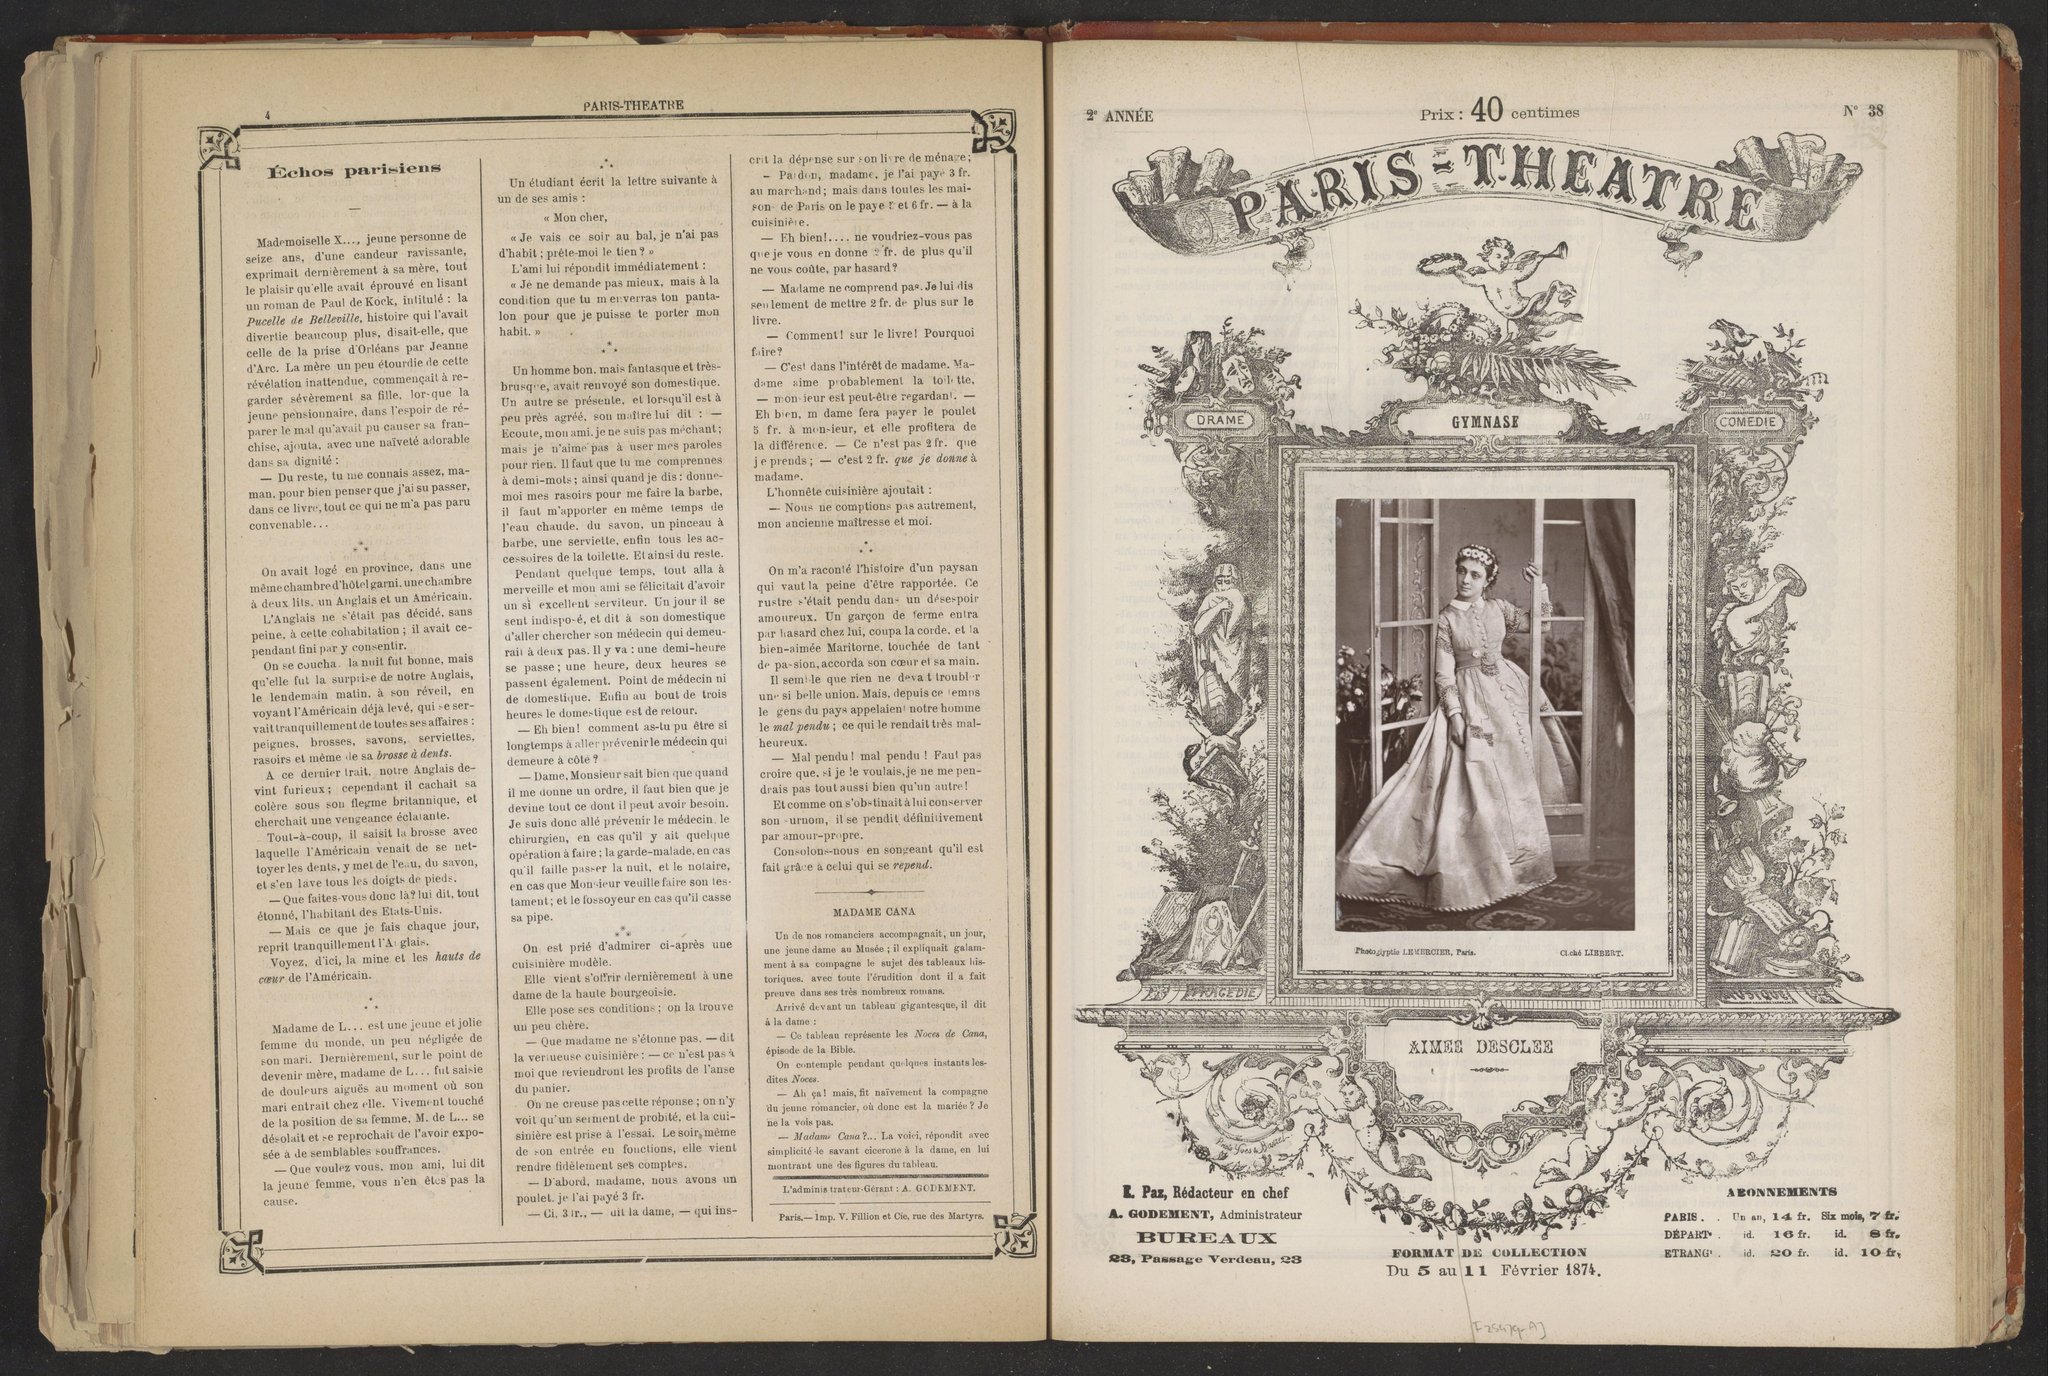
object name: page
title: Aimée Desclée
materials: paper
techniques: woodburytype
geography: france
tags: portrait of actor, actress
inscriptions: inscription: ‘Du 5 au 11 Février 1874.’, number: ‘No 38.’